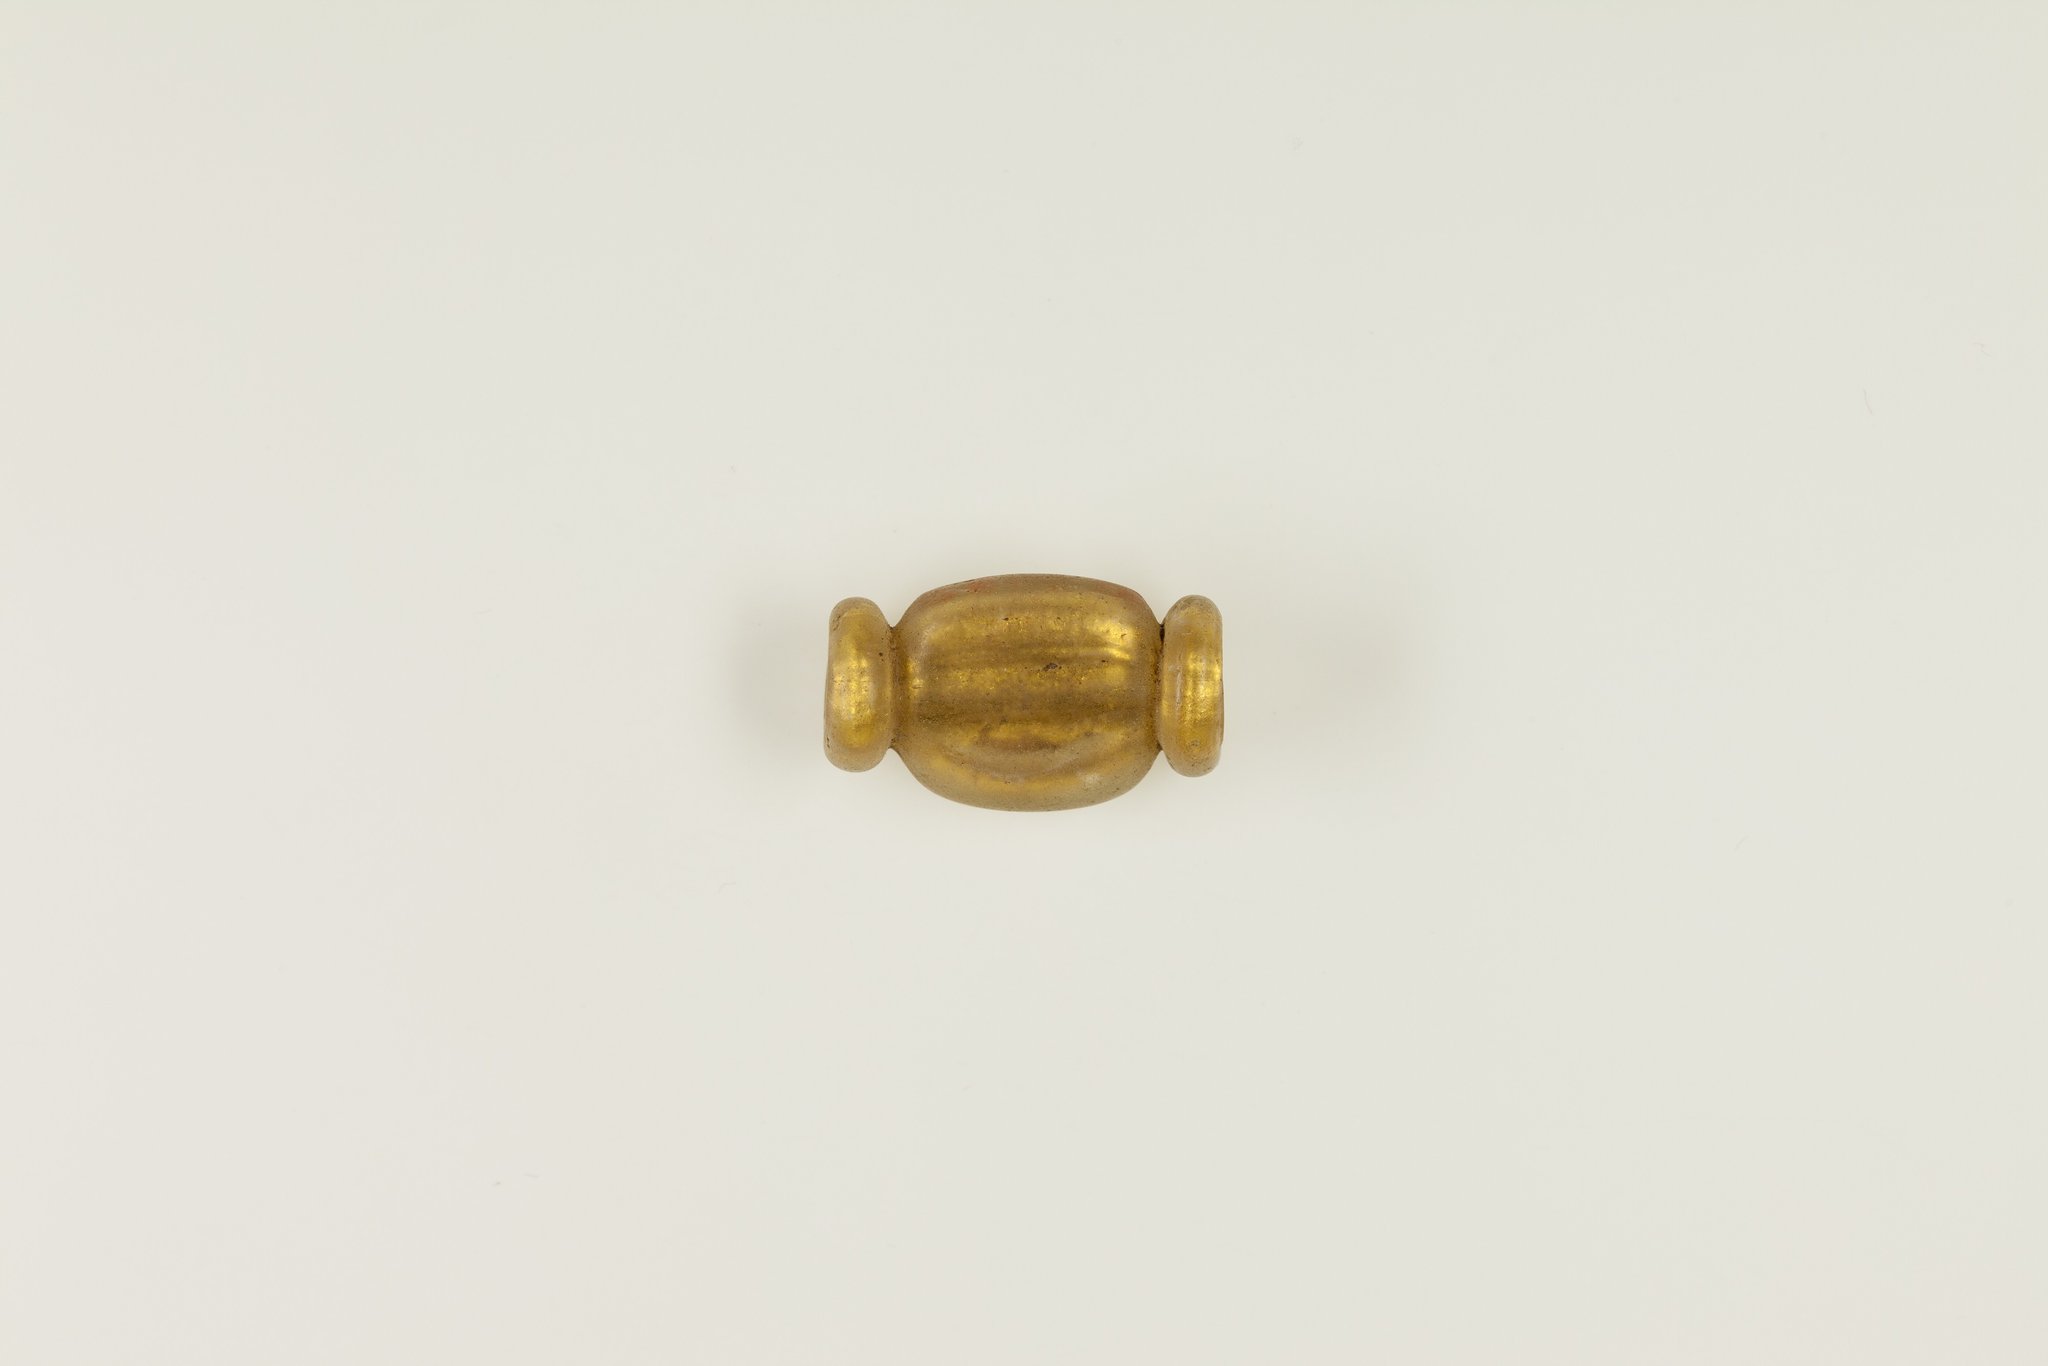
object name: bead, flattened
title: Bead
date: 100 BCE-200 CE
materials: glass, gold foil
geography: egypt